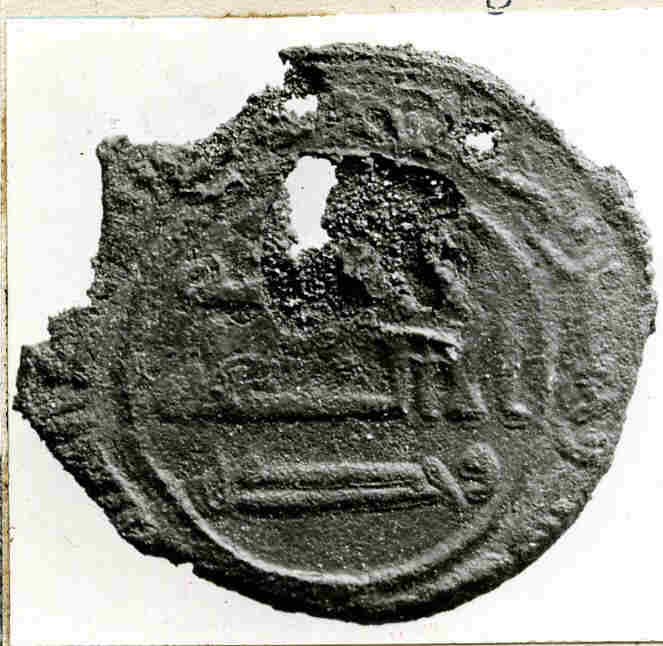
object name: coin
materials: copper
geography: iran